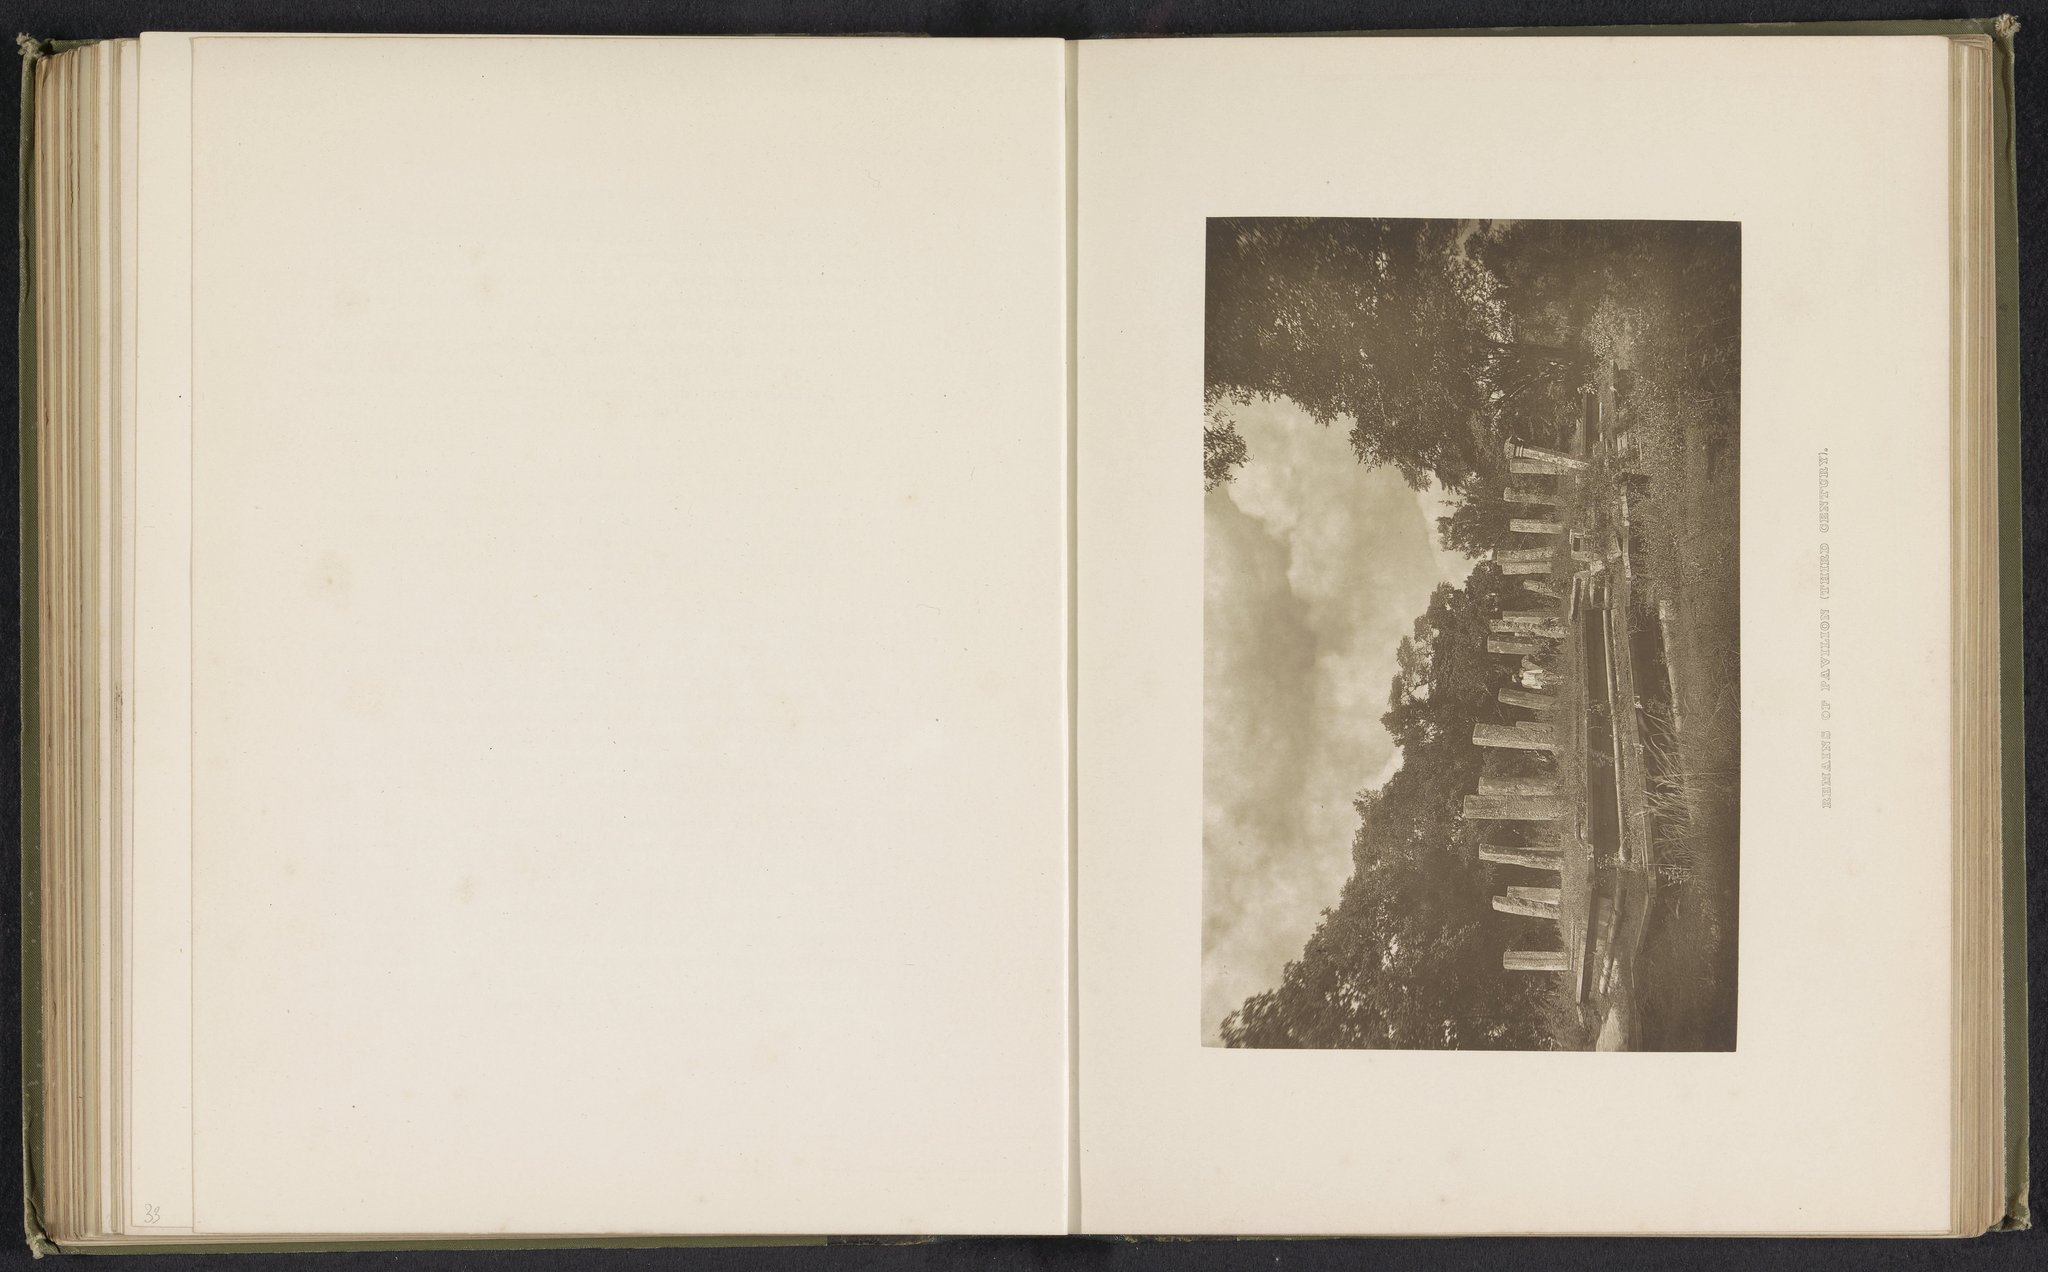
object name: page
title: Ruins of a pavillion at Anuradhapura, Sri Lanka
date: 1896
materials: paper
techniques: woodburygravure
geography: anuradhapura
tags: column, pillar ~ architecture, ruin of a building ~ architecture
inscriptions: title: ‘REMAINS OF PAVILLION (THIRD CENTURY).’